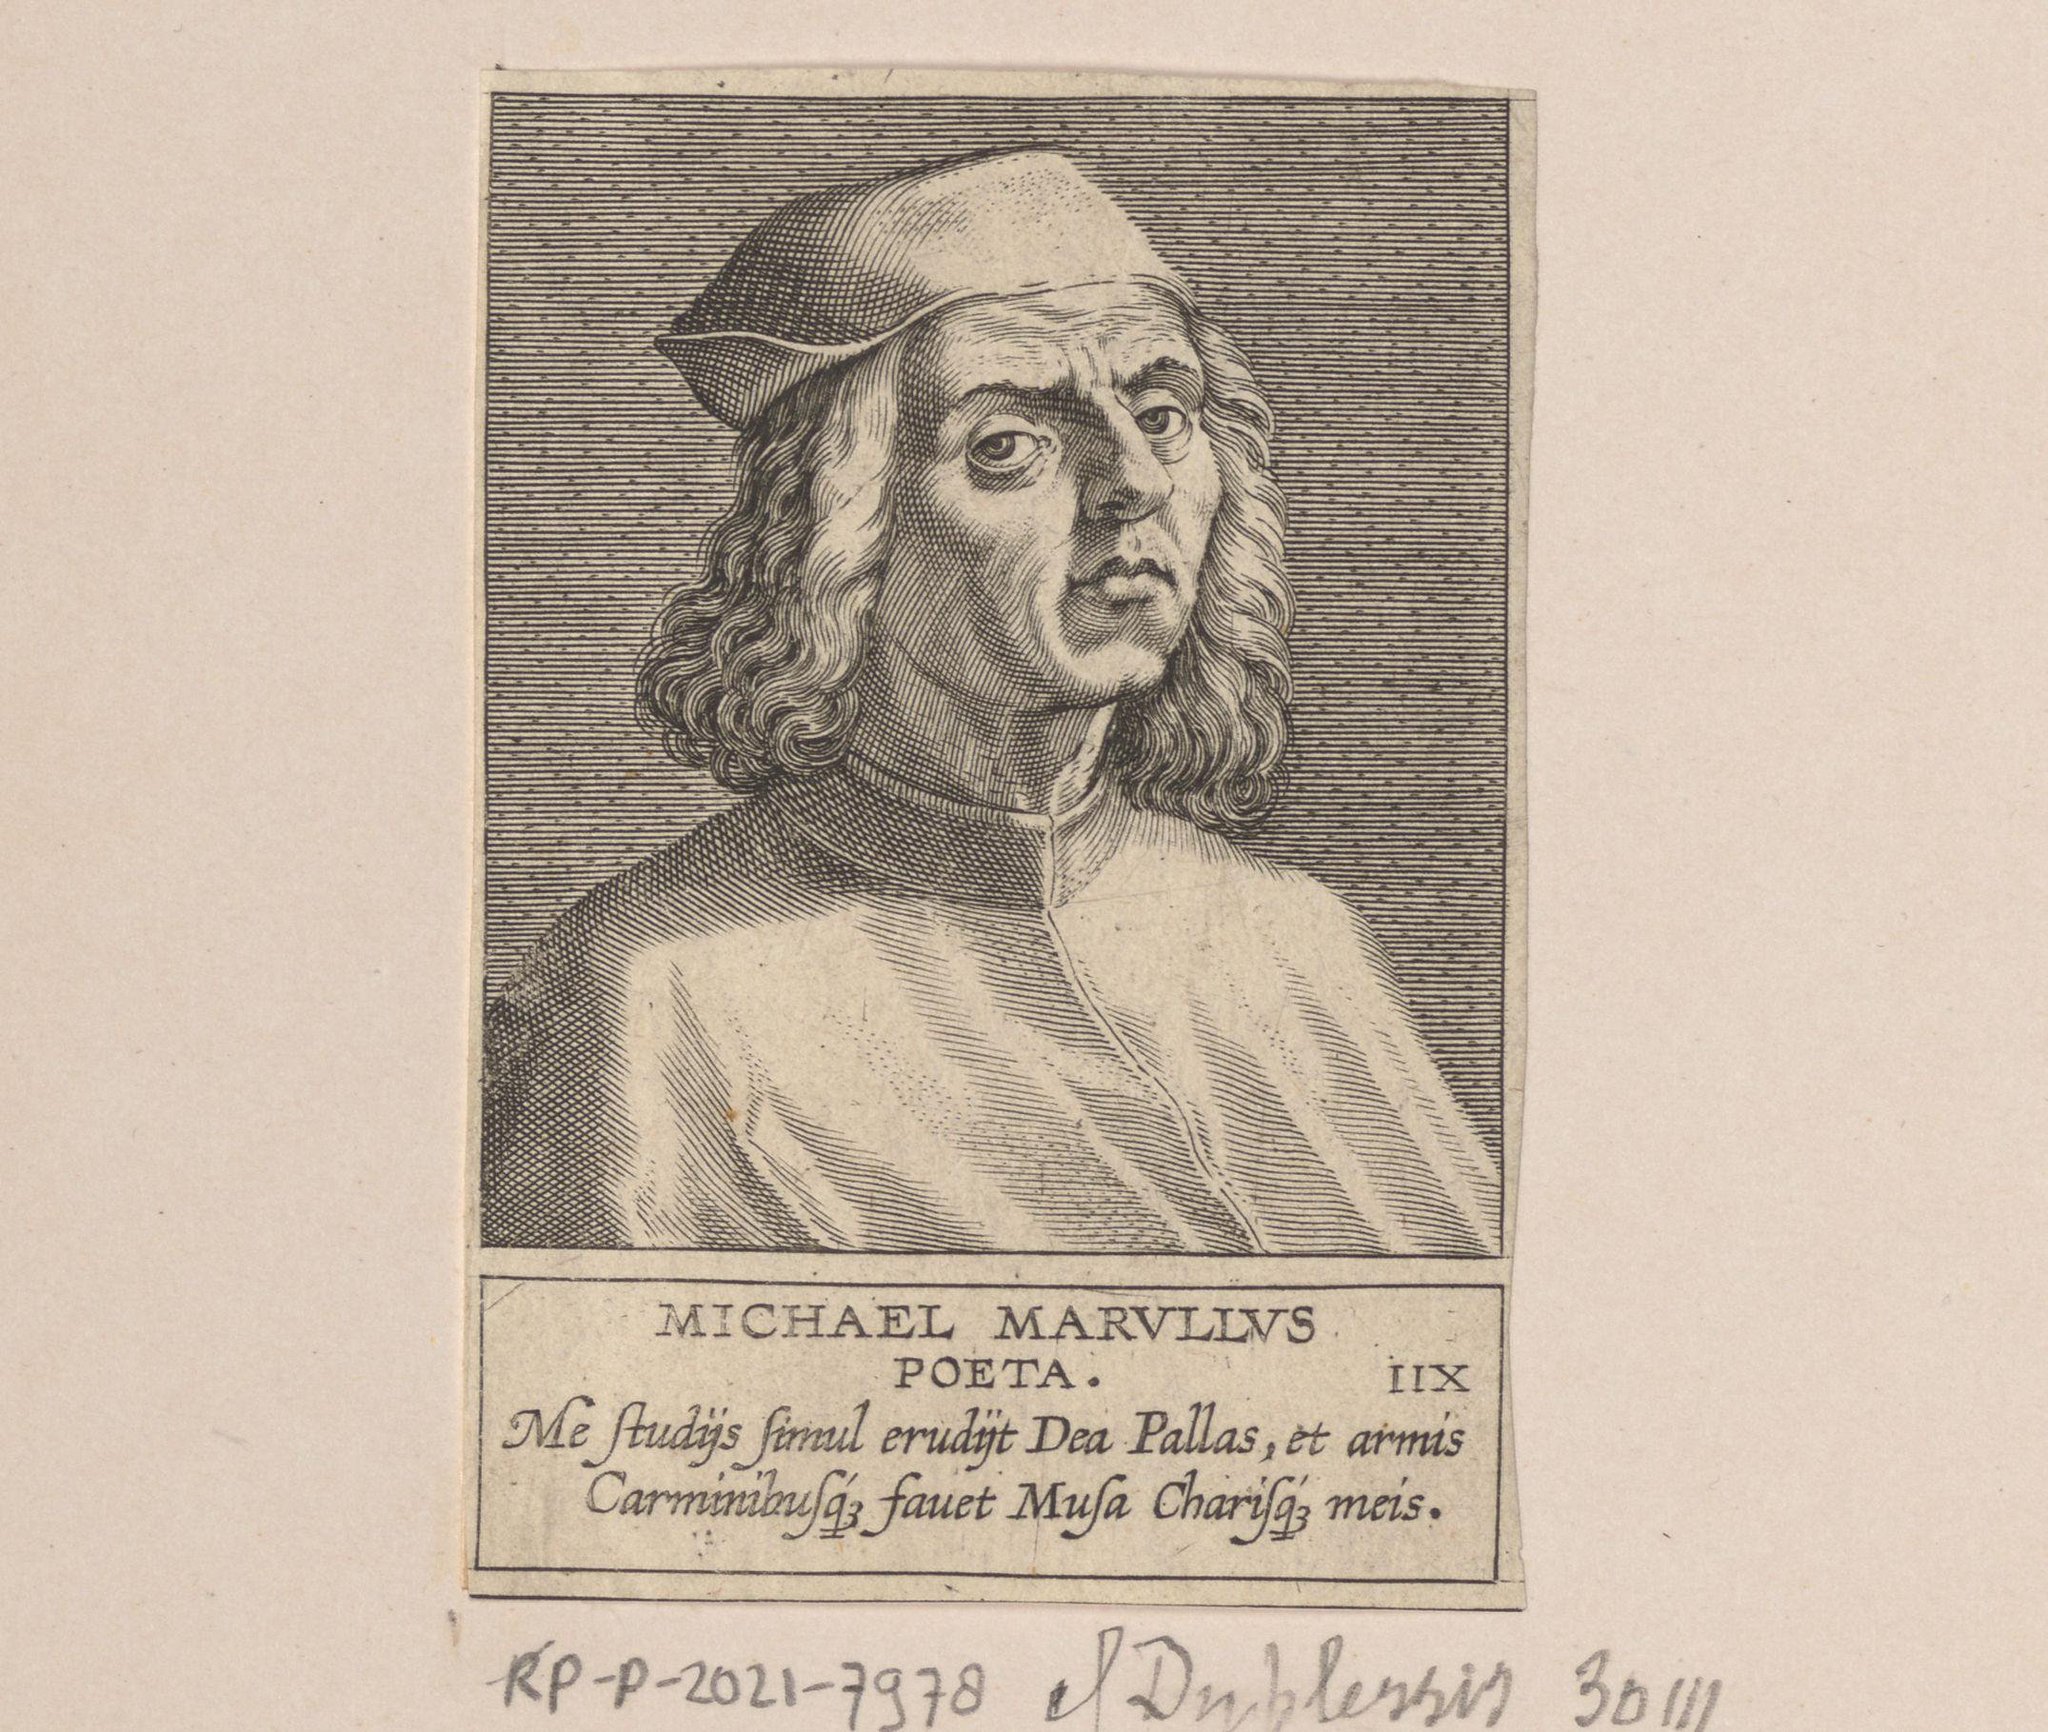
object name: book illustration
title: Portret van Michael Tarchaniota Marullus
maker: jan gerard damperviel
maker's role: print maker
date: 1674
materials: paper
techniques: engraving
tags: historical persons, portrait of a writer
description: Prent geknipt uit een grotere plaat. Prent waarschijnlijk uit: Lambeck, Peter. Sacrae Caesareae Maiestatis Consiliarii (...). Wenen: Matthäus Cosmerovius, 1674, dl. 6.